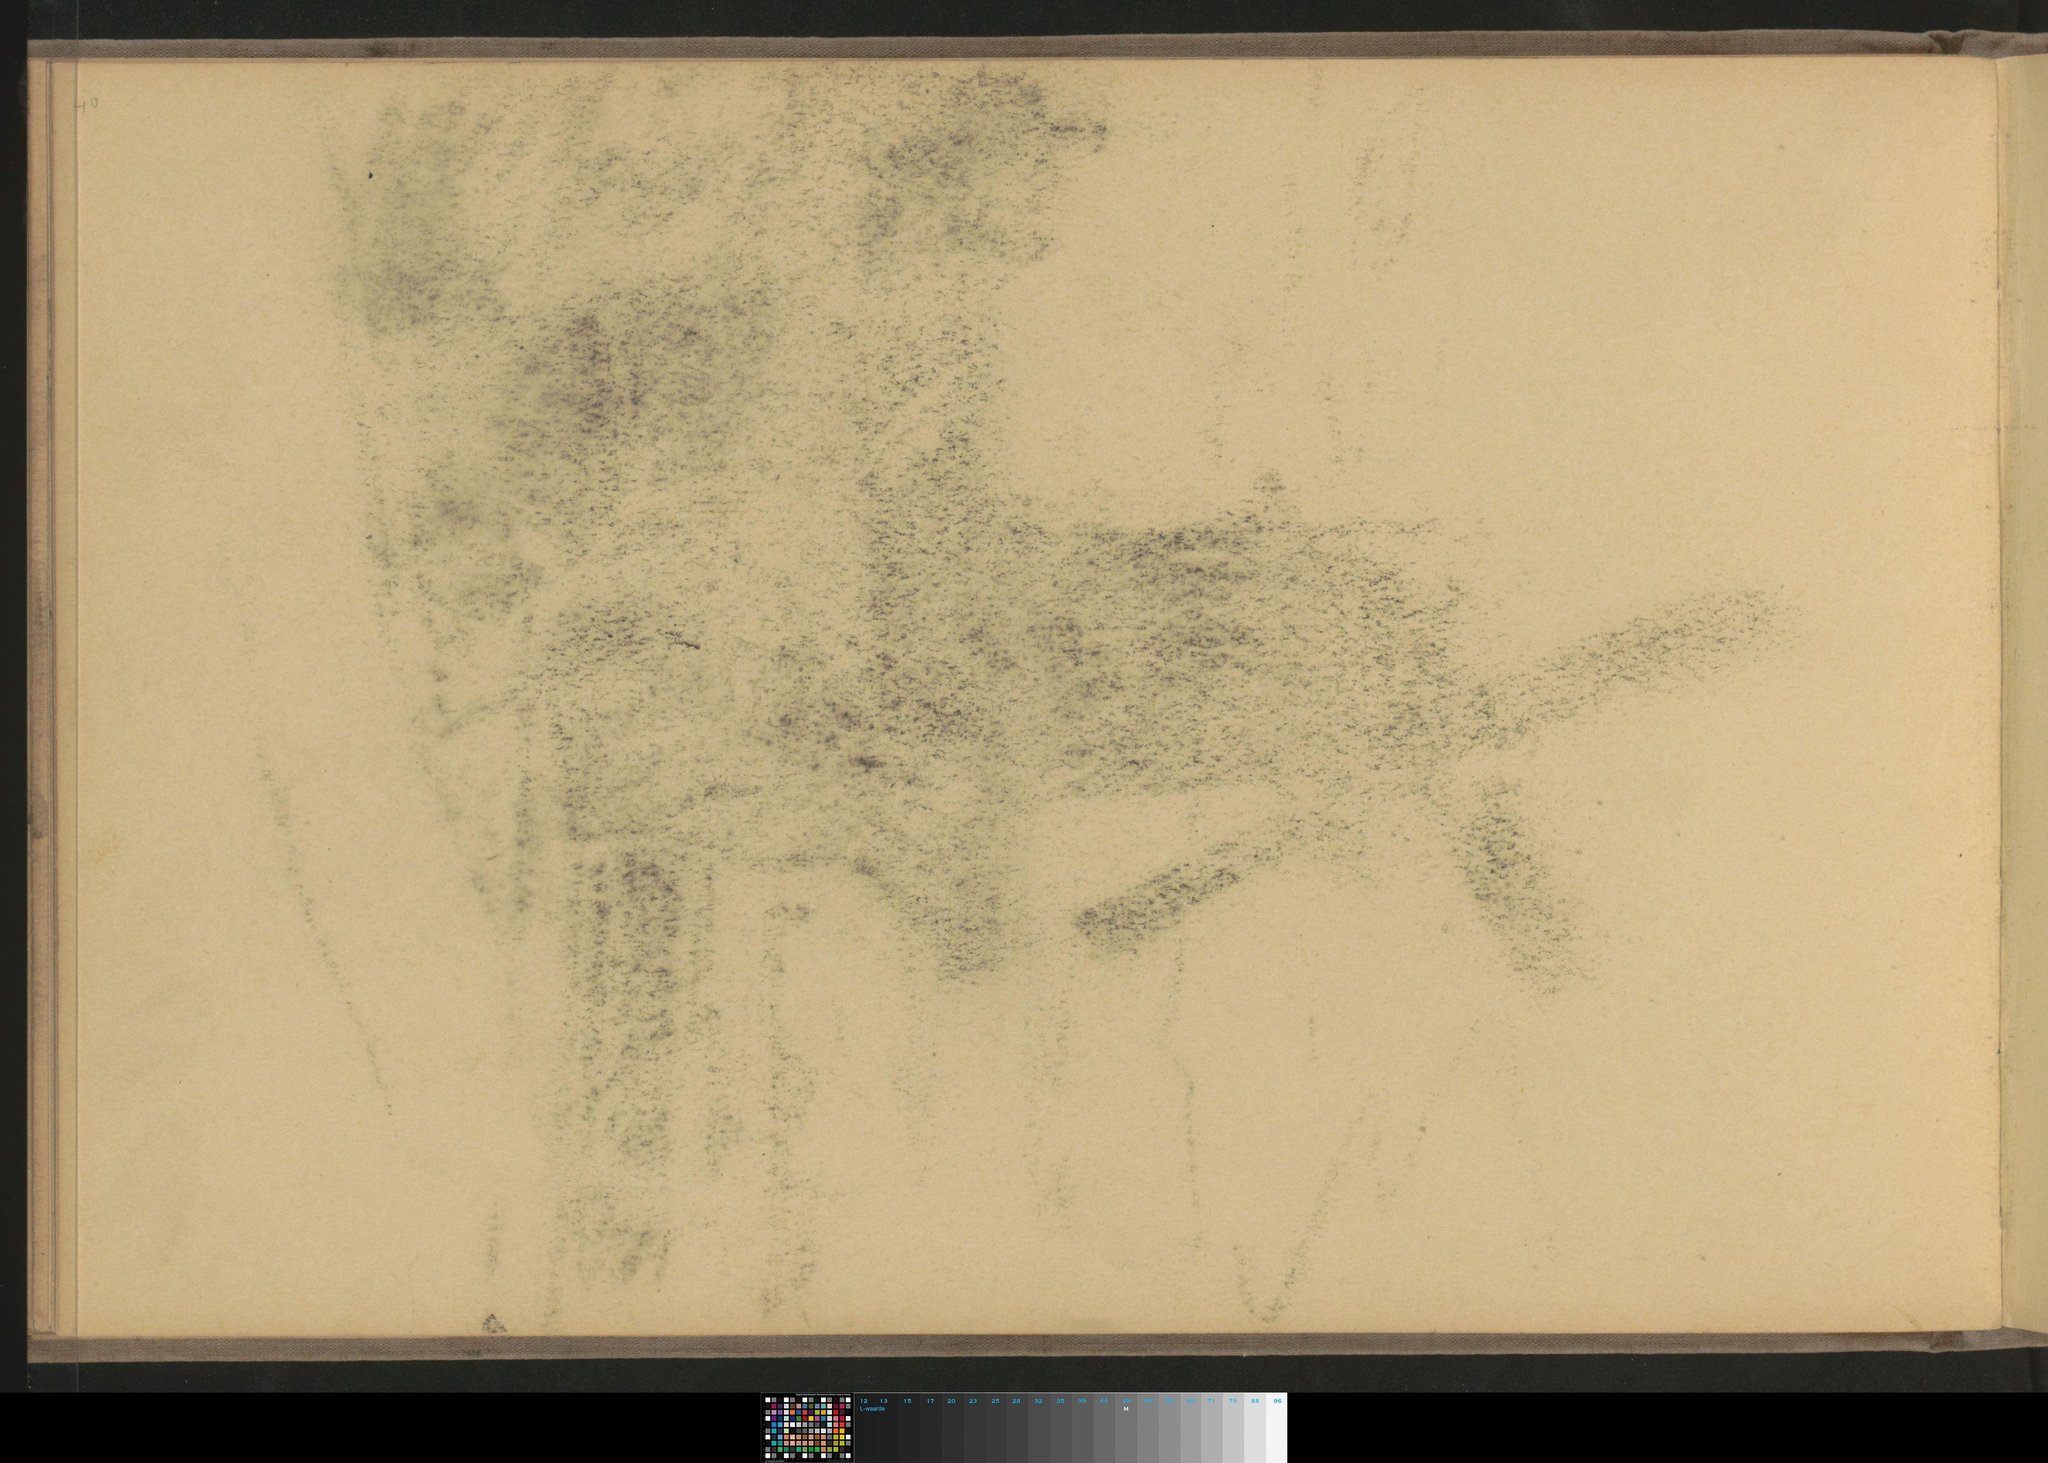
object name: sketchbook leaf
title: Abklatsch van de krijttekening op pagina 41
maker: willem witsen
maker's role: draughtsman, painter, print maker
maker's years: 1860-1923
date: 1901-1907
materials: paper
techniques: printmaking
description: Pagina 40 uit een schetsboek met 60 bladen.